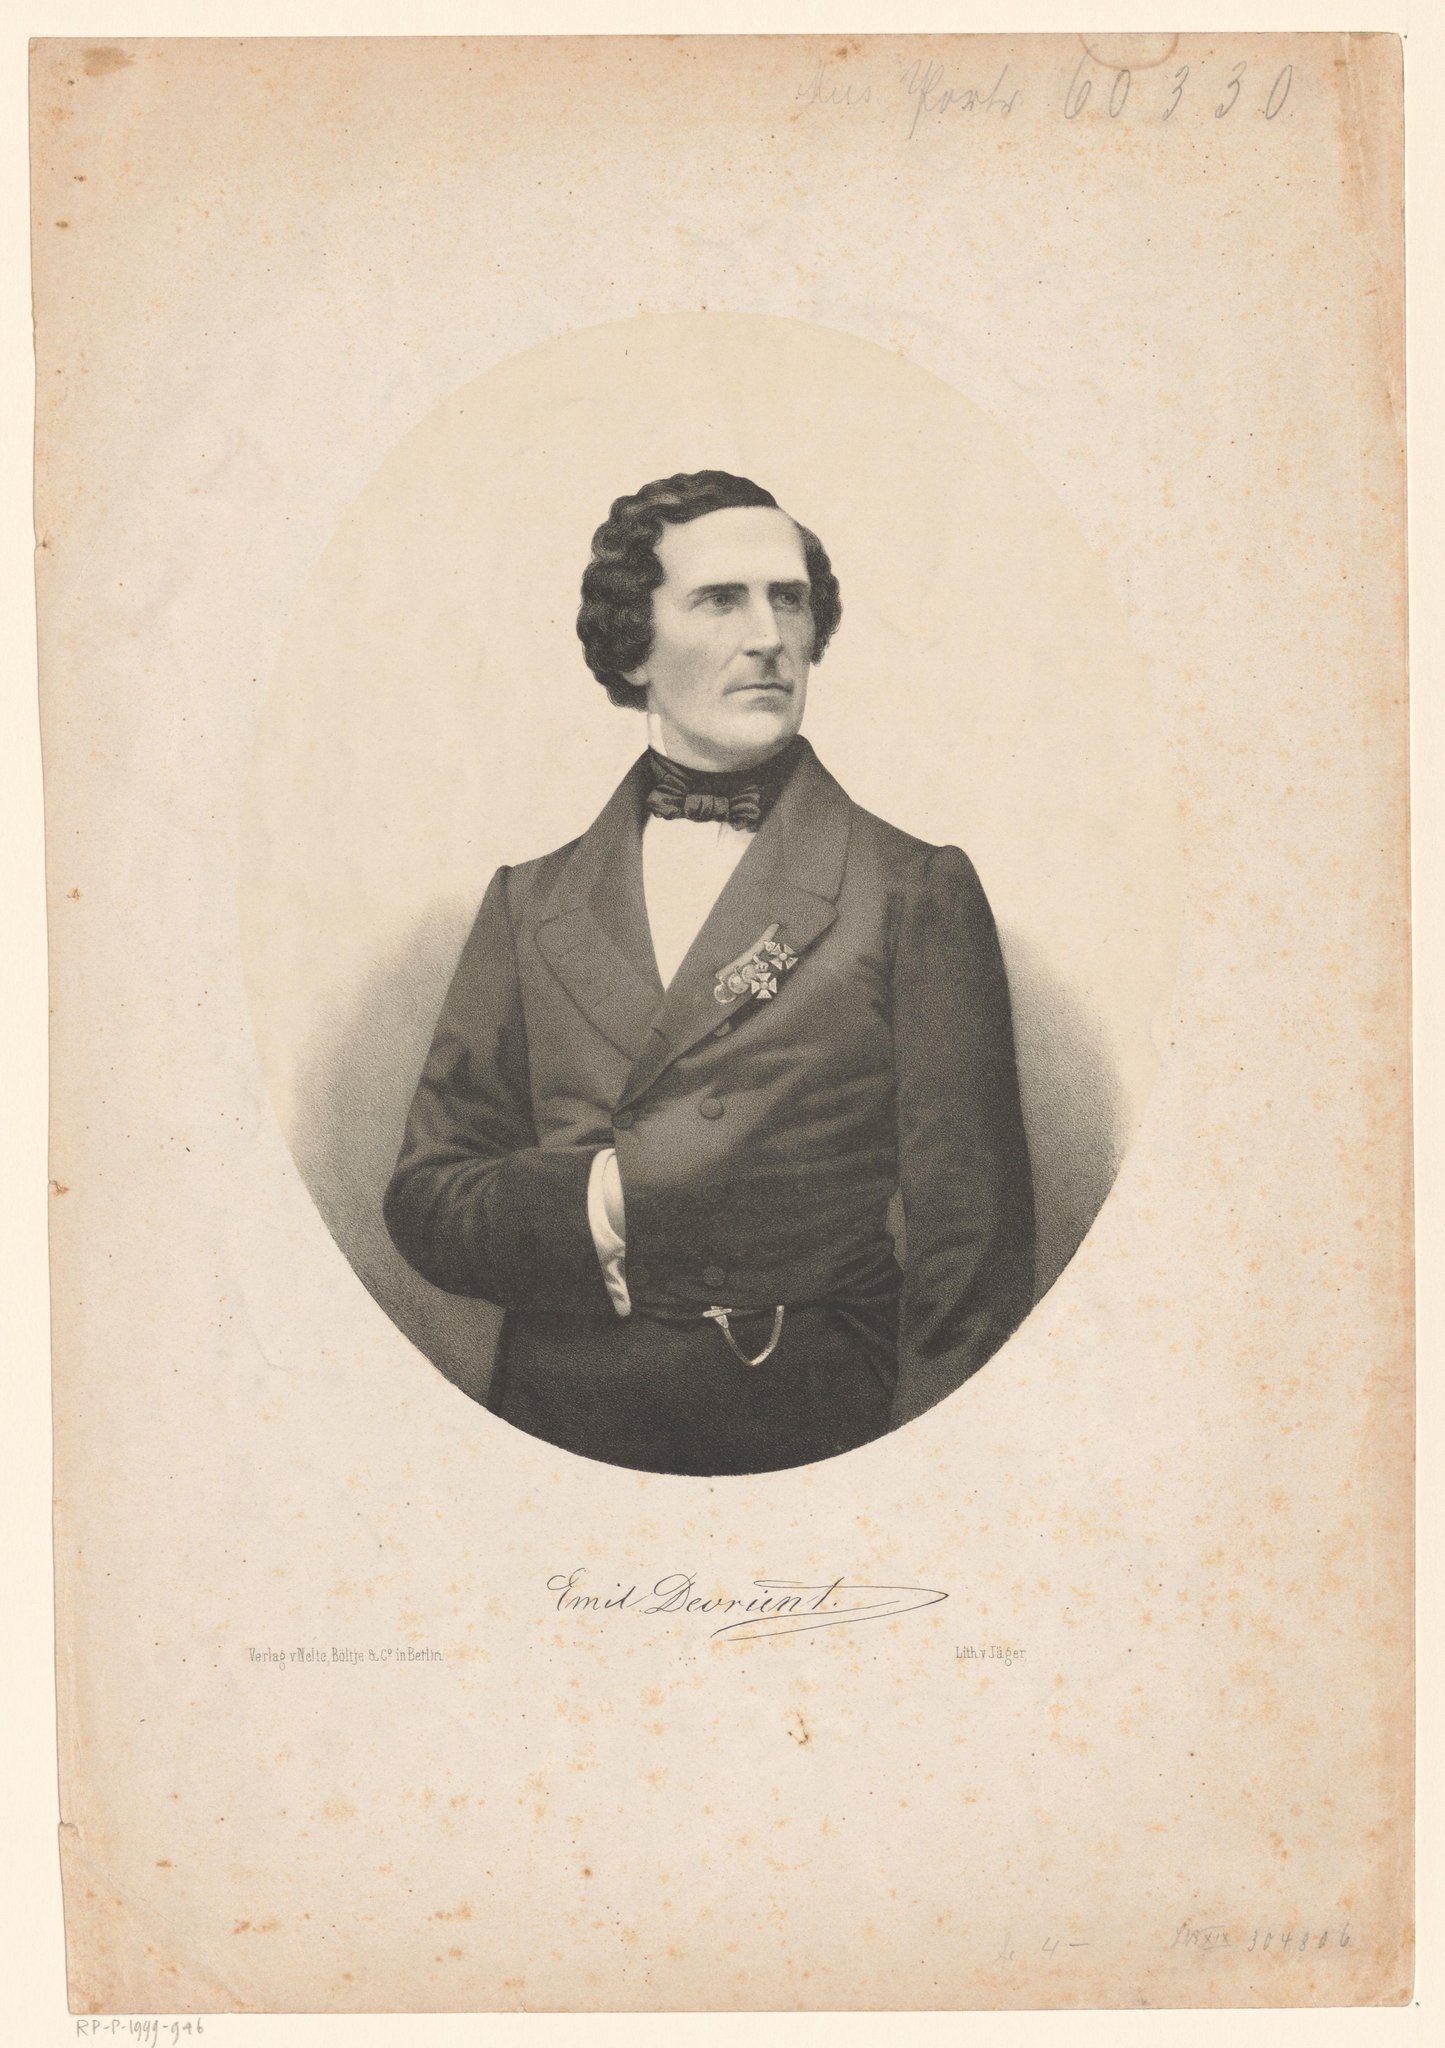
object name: print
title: Portret van Emil Devrient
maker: jäger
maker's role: lithograaf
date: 1820-1899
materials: paper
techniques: tone lithography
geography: berlin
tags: adult man, historical persons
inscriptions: inscription: ‘Mus Portr. 60330/ LB XIX 304806’, stamp: ‘Franz Radestock’, collector's mark: Lugt 2228, collector's mark: Lugt 2760